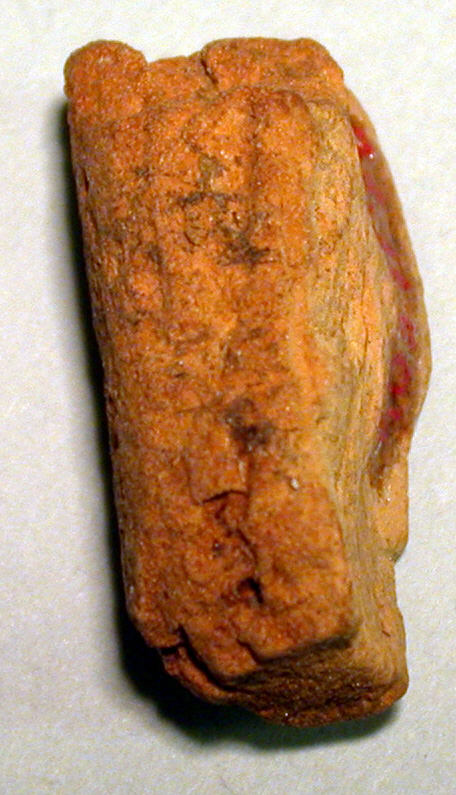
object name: cuneiform tablet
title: Cuneiform tablet: fragment, content uncertain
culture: achaemenid or babylonian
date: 700-301 BCE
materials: clay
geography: mesopotamia